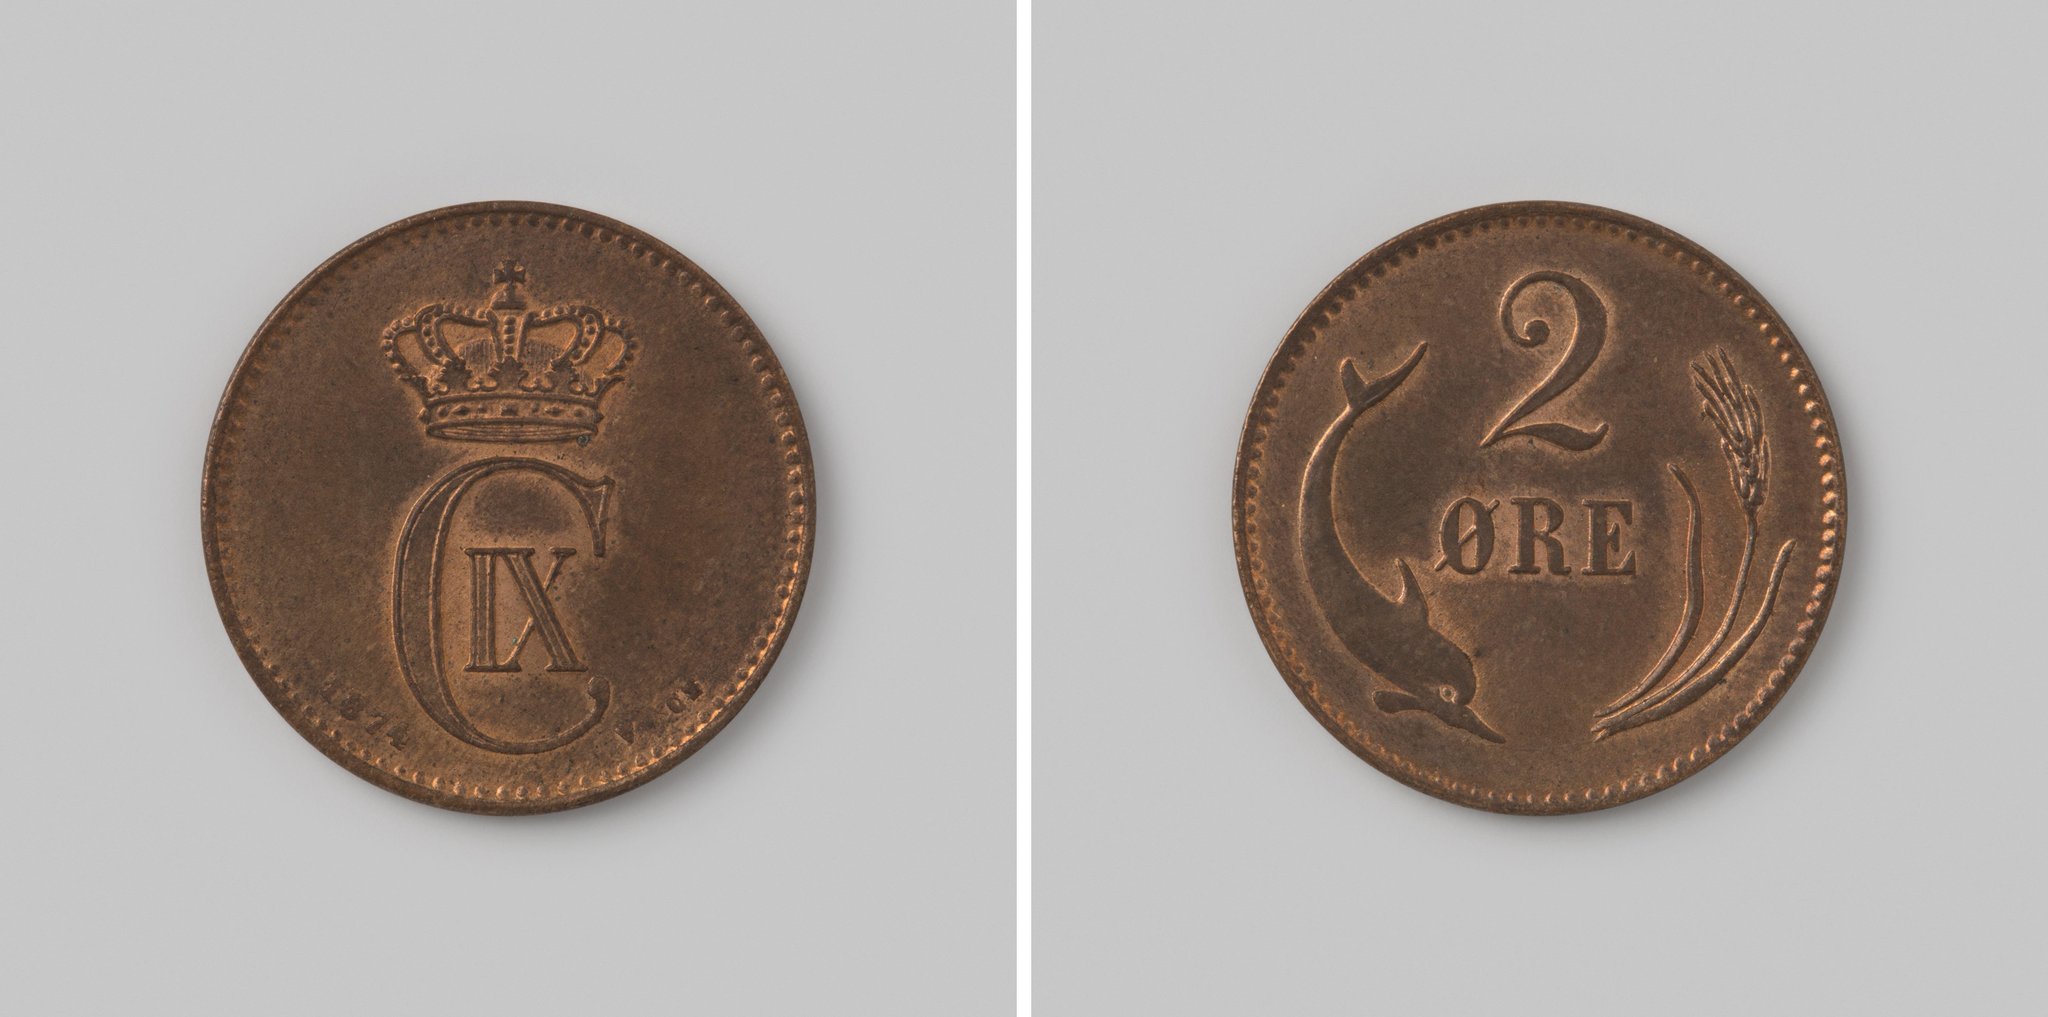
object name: coin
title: Denemarken, Christiaan IX, 2 øre, 1874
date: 1874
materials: bronze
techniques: striking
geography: copenhagen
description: Bronzen munt. Voorzijde: gekroond monogram van de koning. Daaronder links jaartal. Keerzijde: tussen dolfijn en tak in twee regels waarde-aanduiding. Gladde rand.